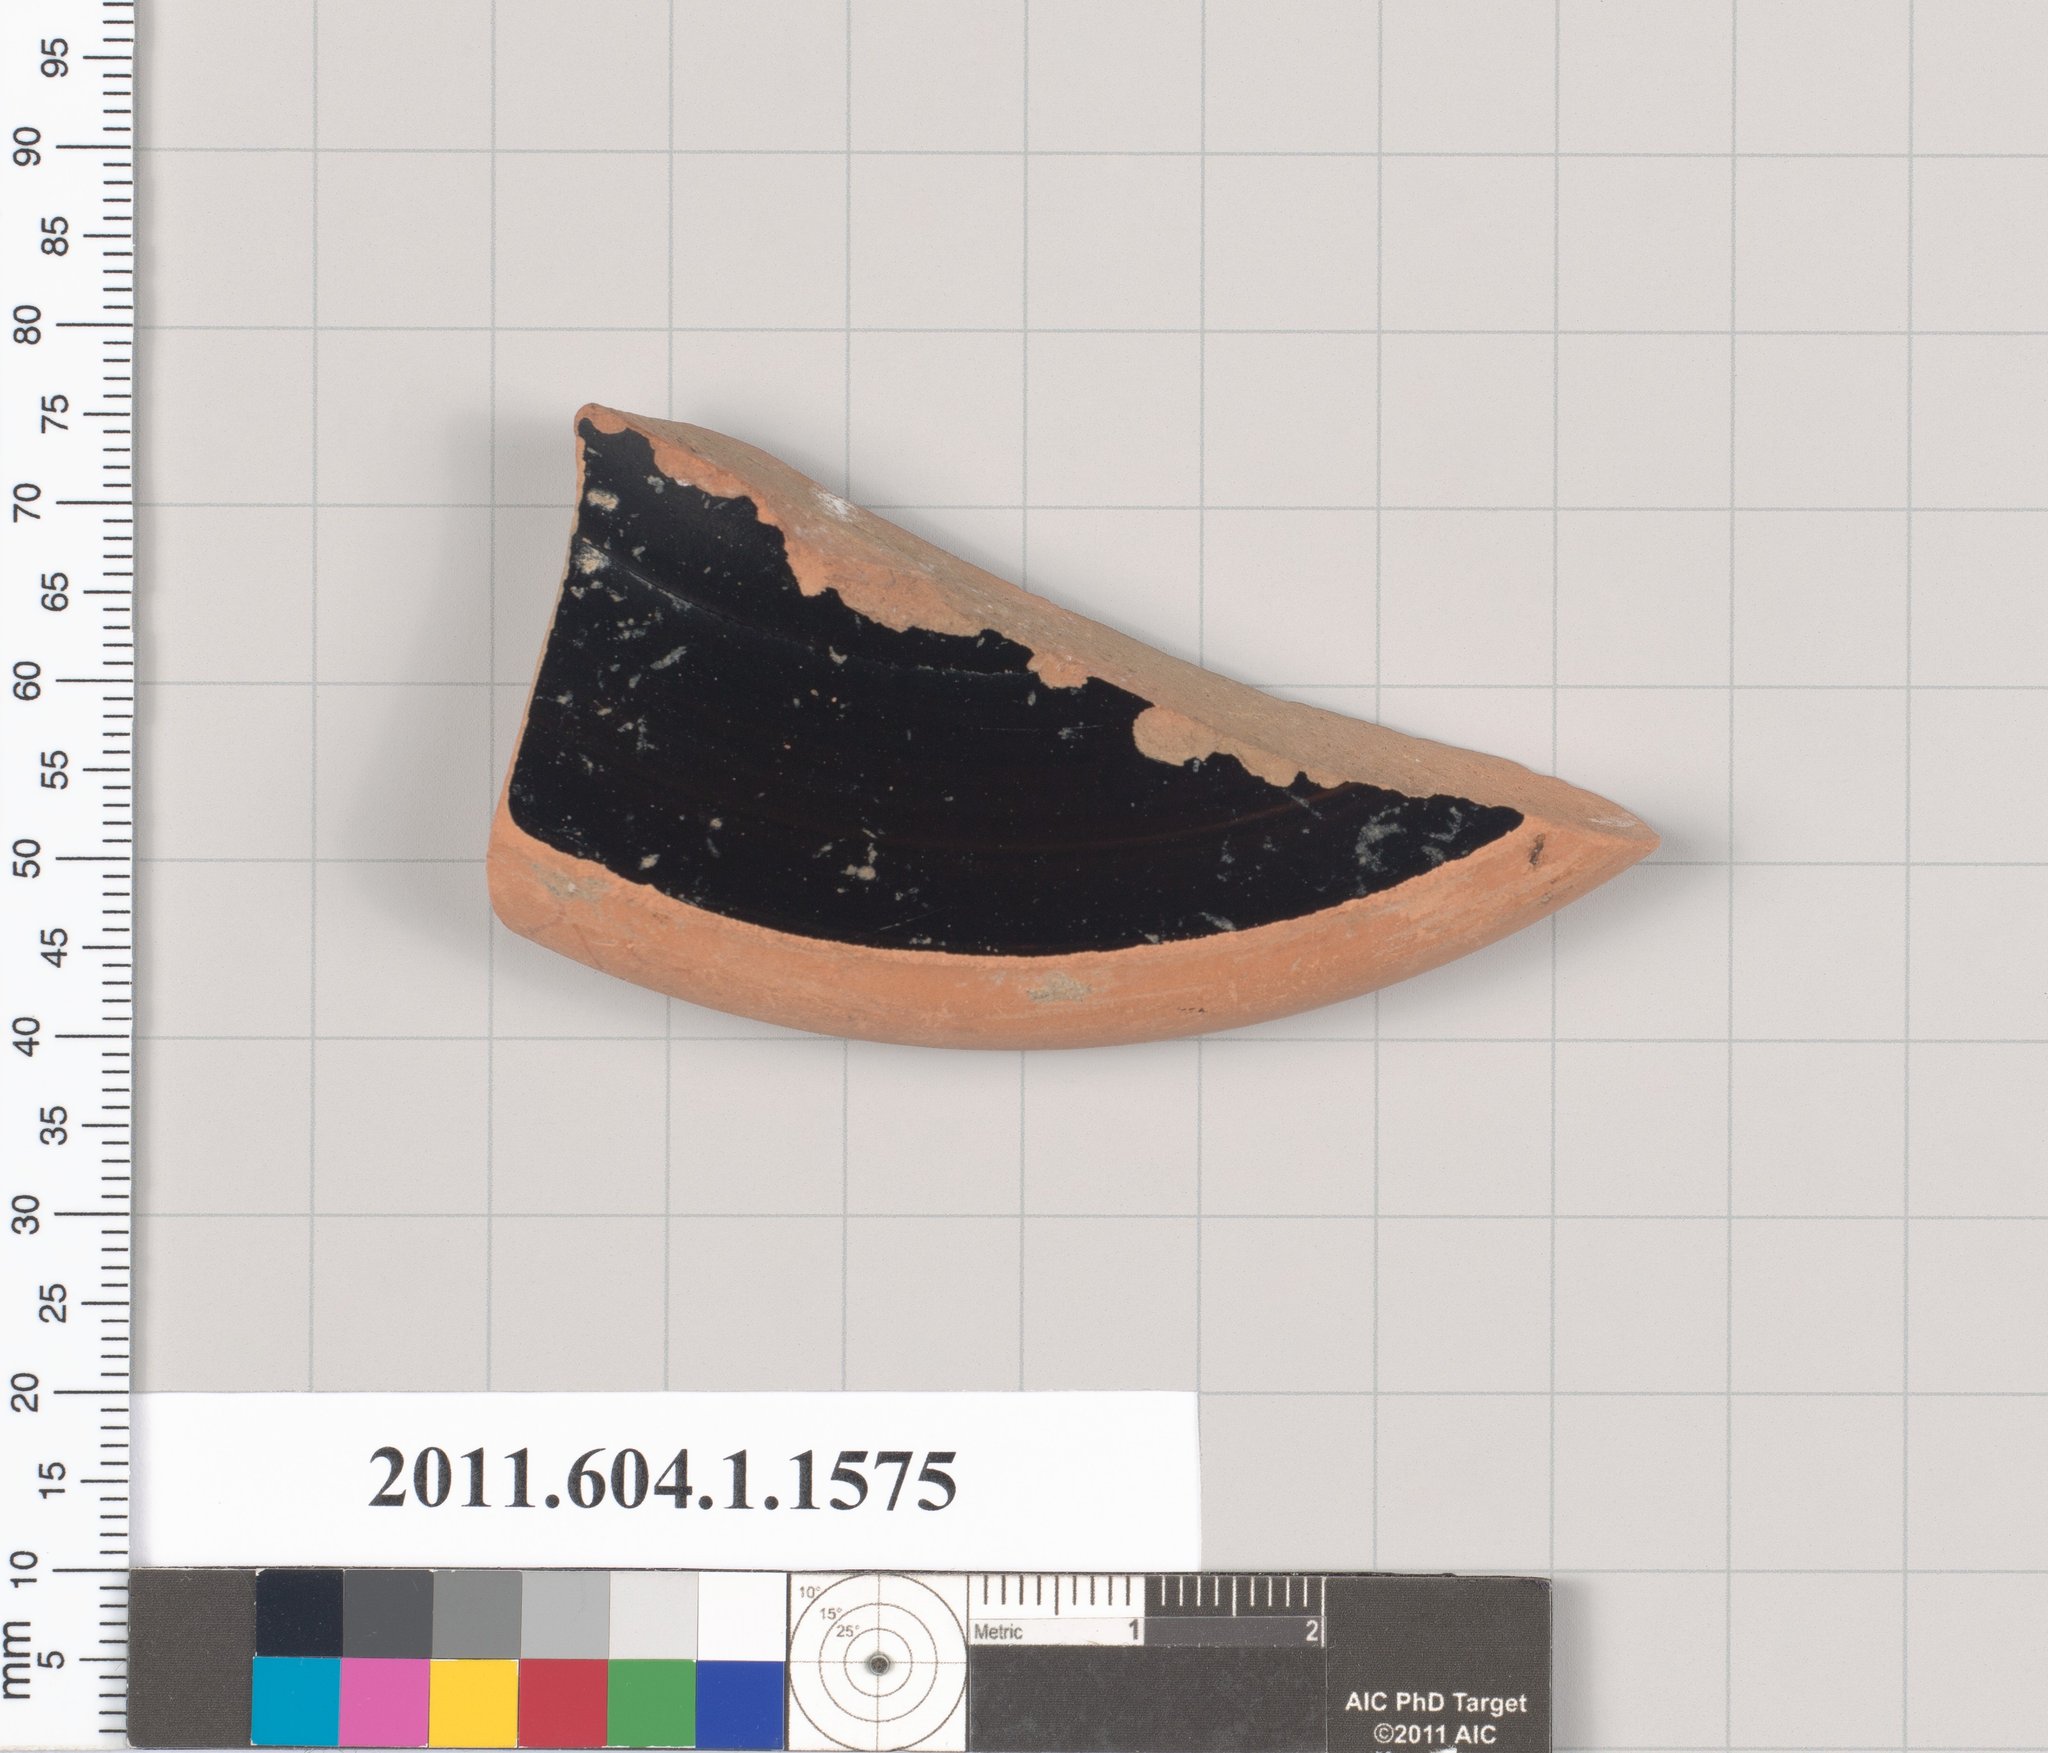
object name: kylix fragment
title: Terracotta fragment of a kylix (drinking cup)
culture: greek, attic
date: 500-401 BCE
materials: terracotta